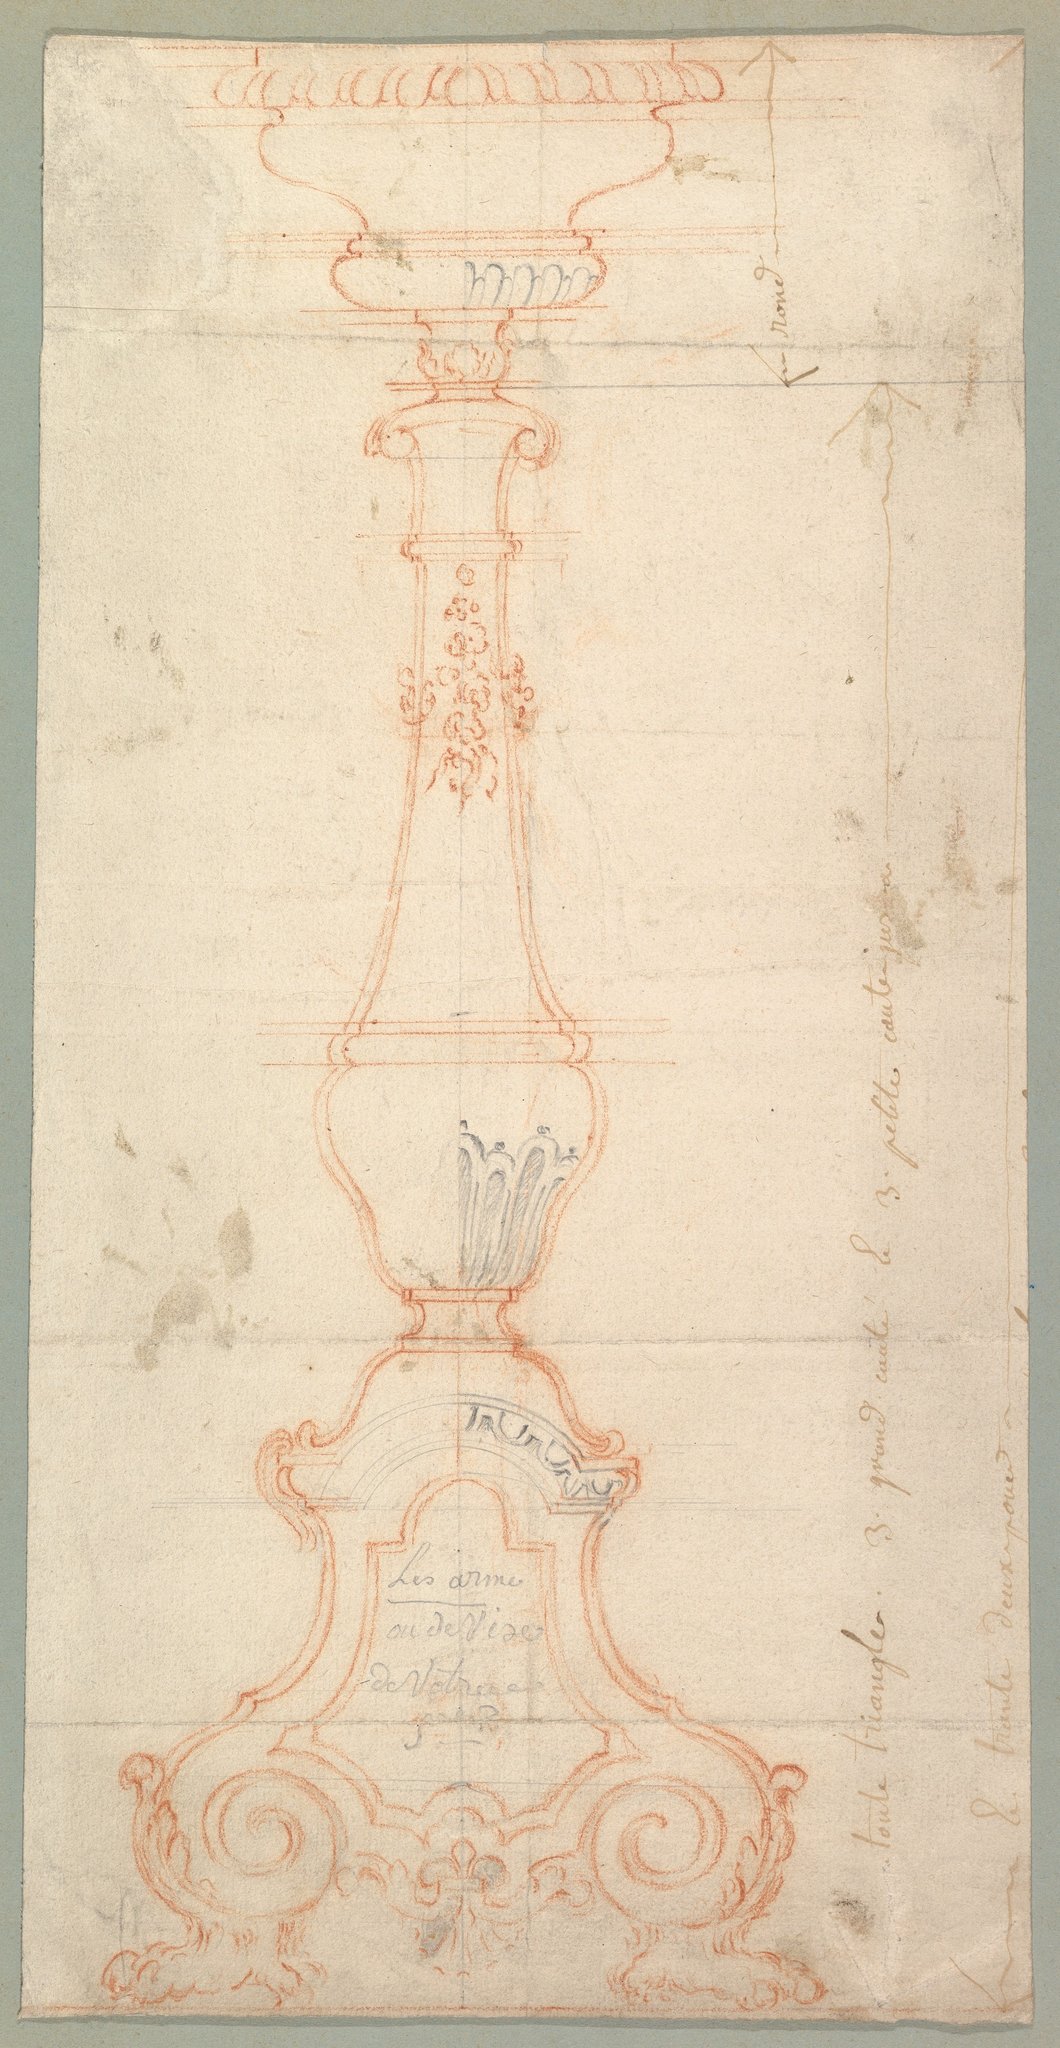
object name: drawing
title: Design for a Candlestick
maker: anonymous, french, 18th century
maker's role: artist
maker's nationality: french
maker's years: 1700-1800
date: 1701-1800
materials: chalk, graphite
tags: candlesticks